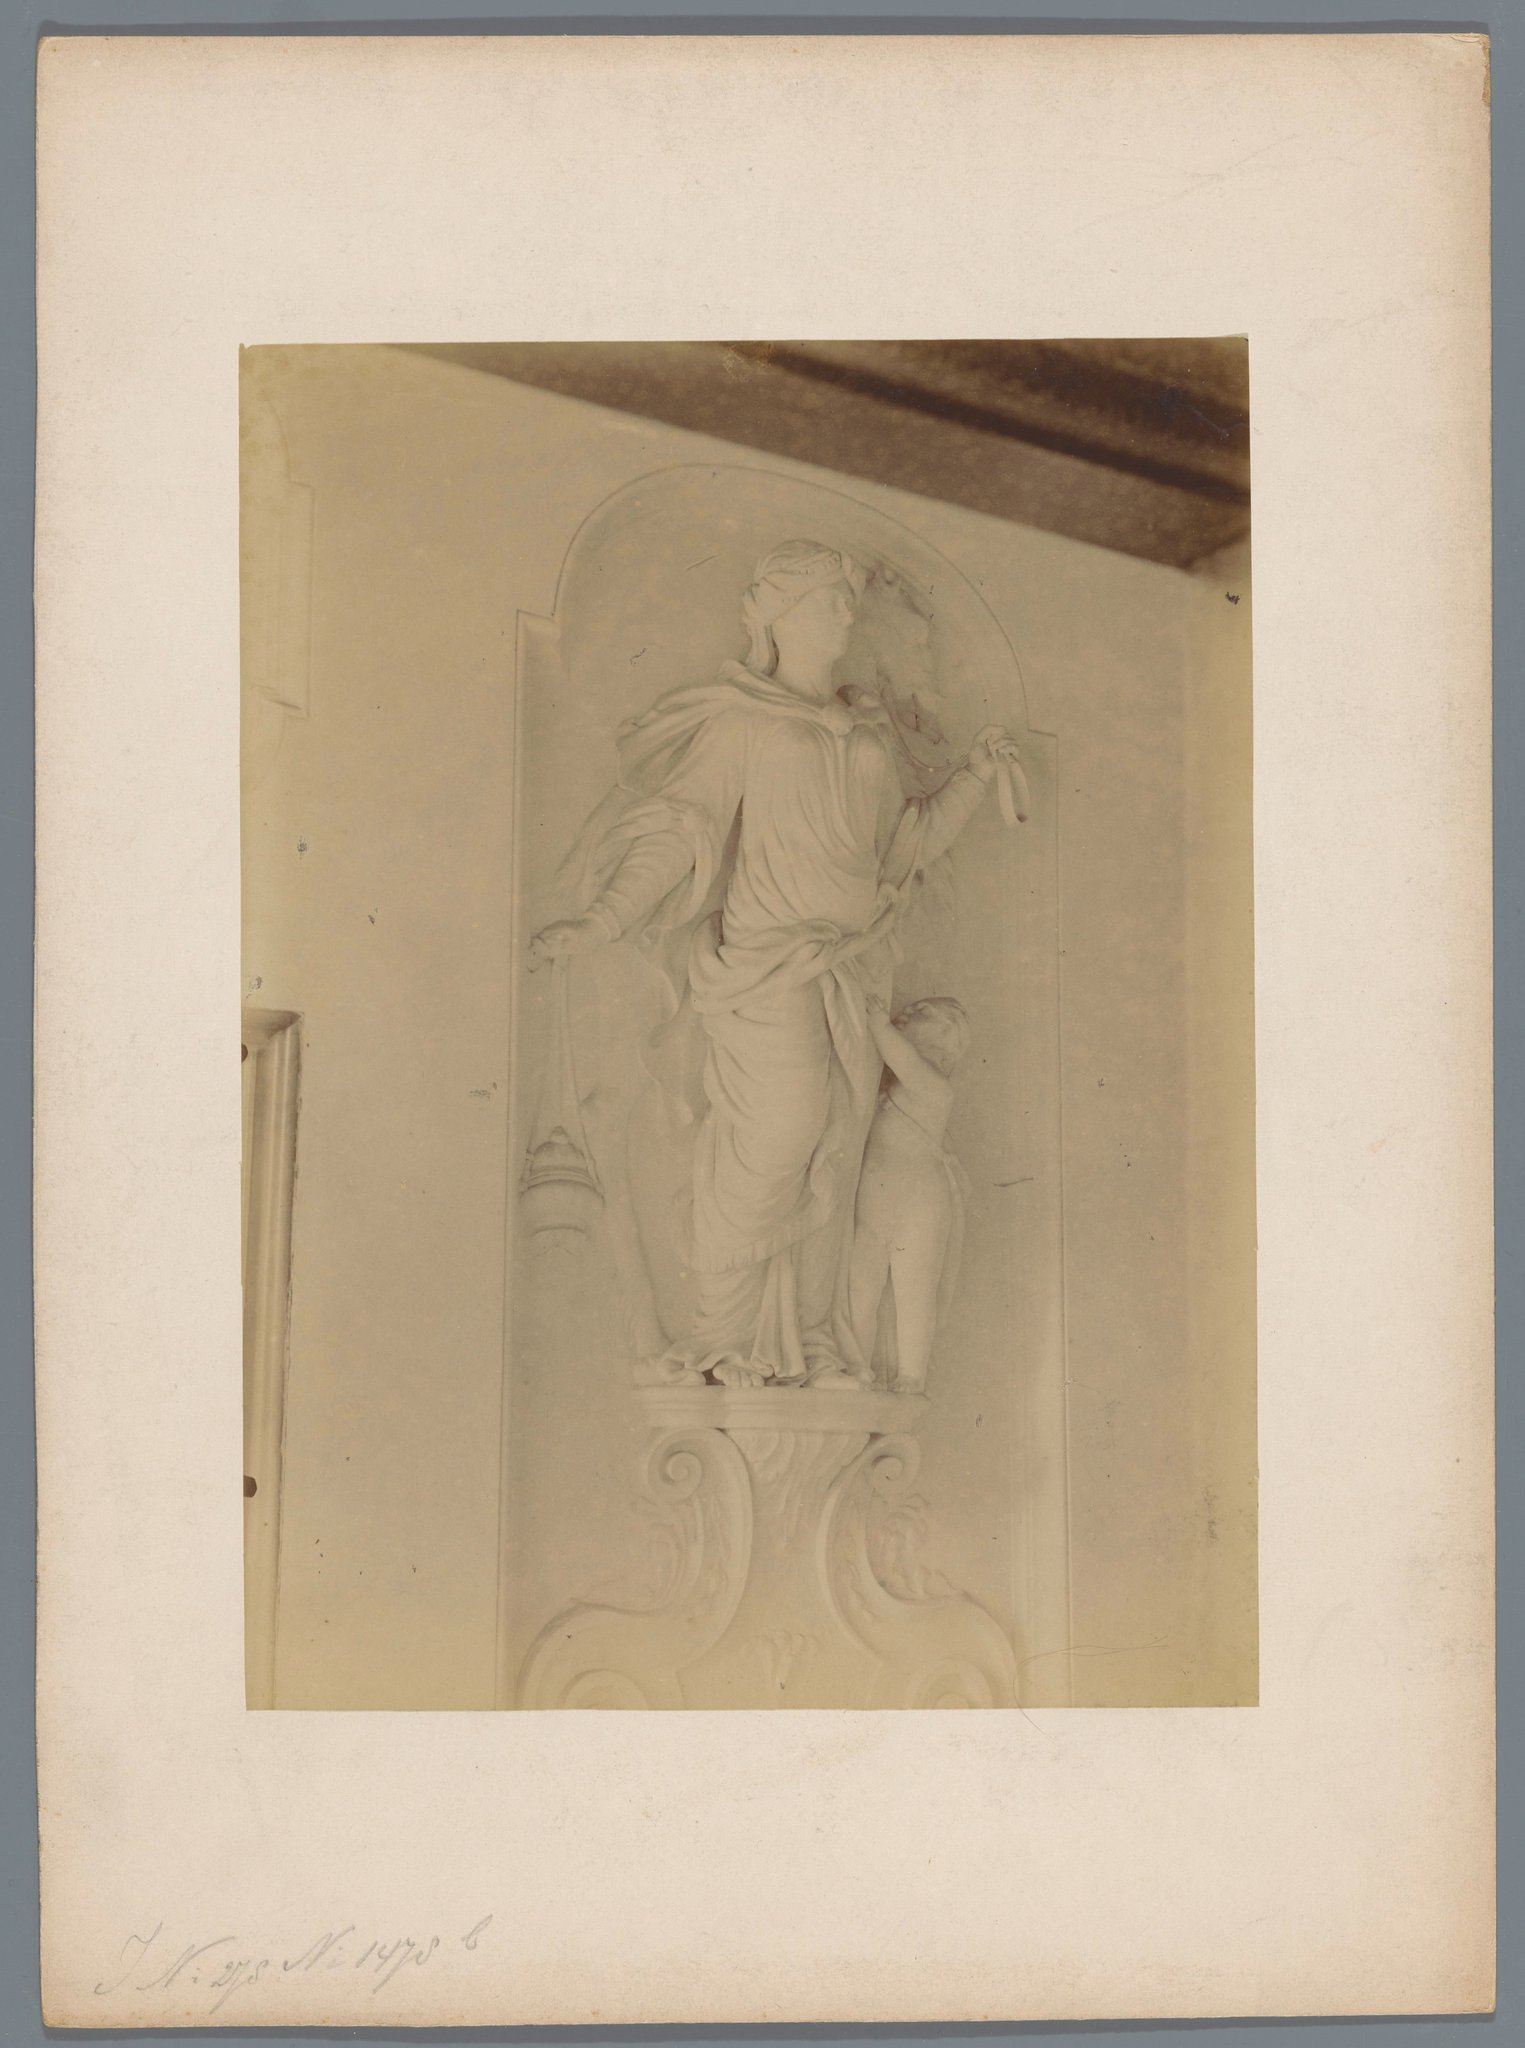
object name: photograph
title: Stuccobeeld in Huis ter Meer te Maarssen, voorstellende het continent Azië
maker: Anonymous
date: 1875-1900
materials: cardboard, photographic support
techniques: albumen print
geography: huis ter meer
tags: head-gear: turban, sculpture, incense-burner ~ scents, perfumes, interior ~ representation of a building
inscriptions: annotation, inscription: ‘neg. no 15959 foto 22305’, inscription: ‘Maarsen, U Huis ter Meer. gesloopt Aug. 1903 Een der stucco beelden in de gang.’